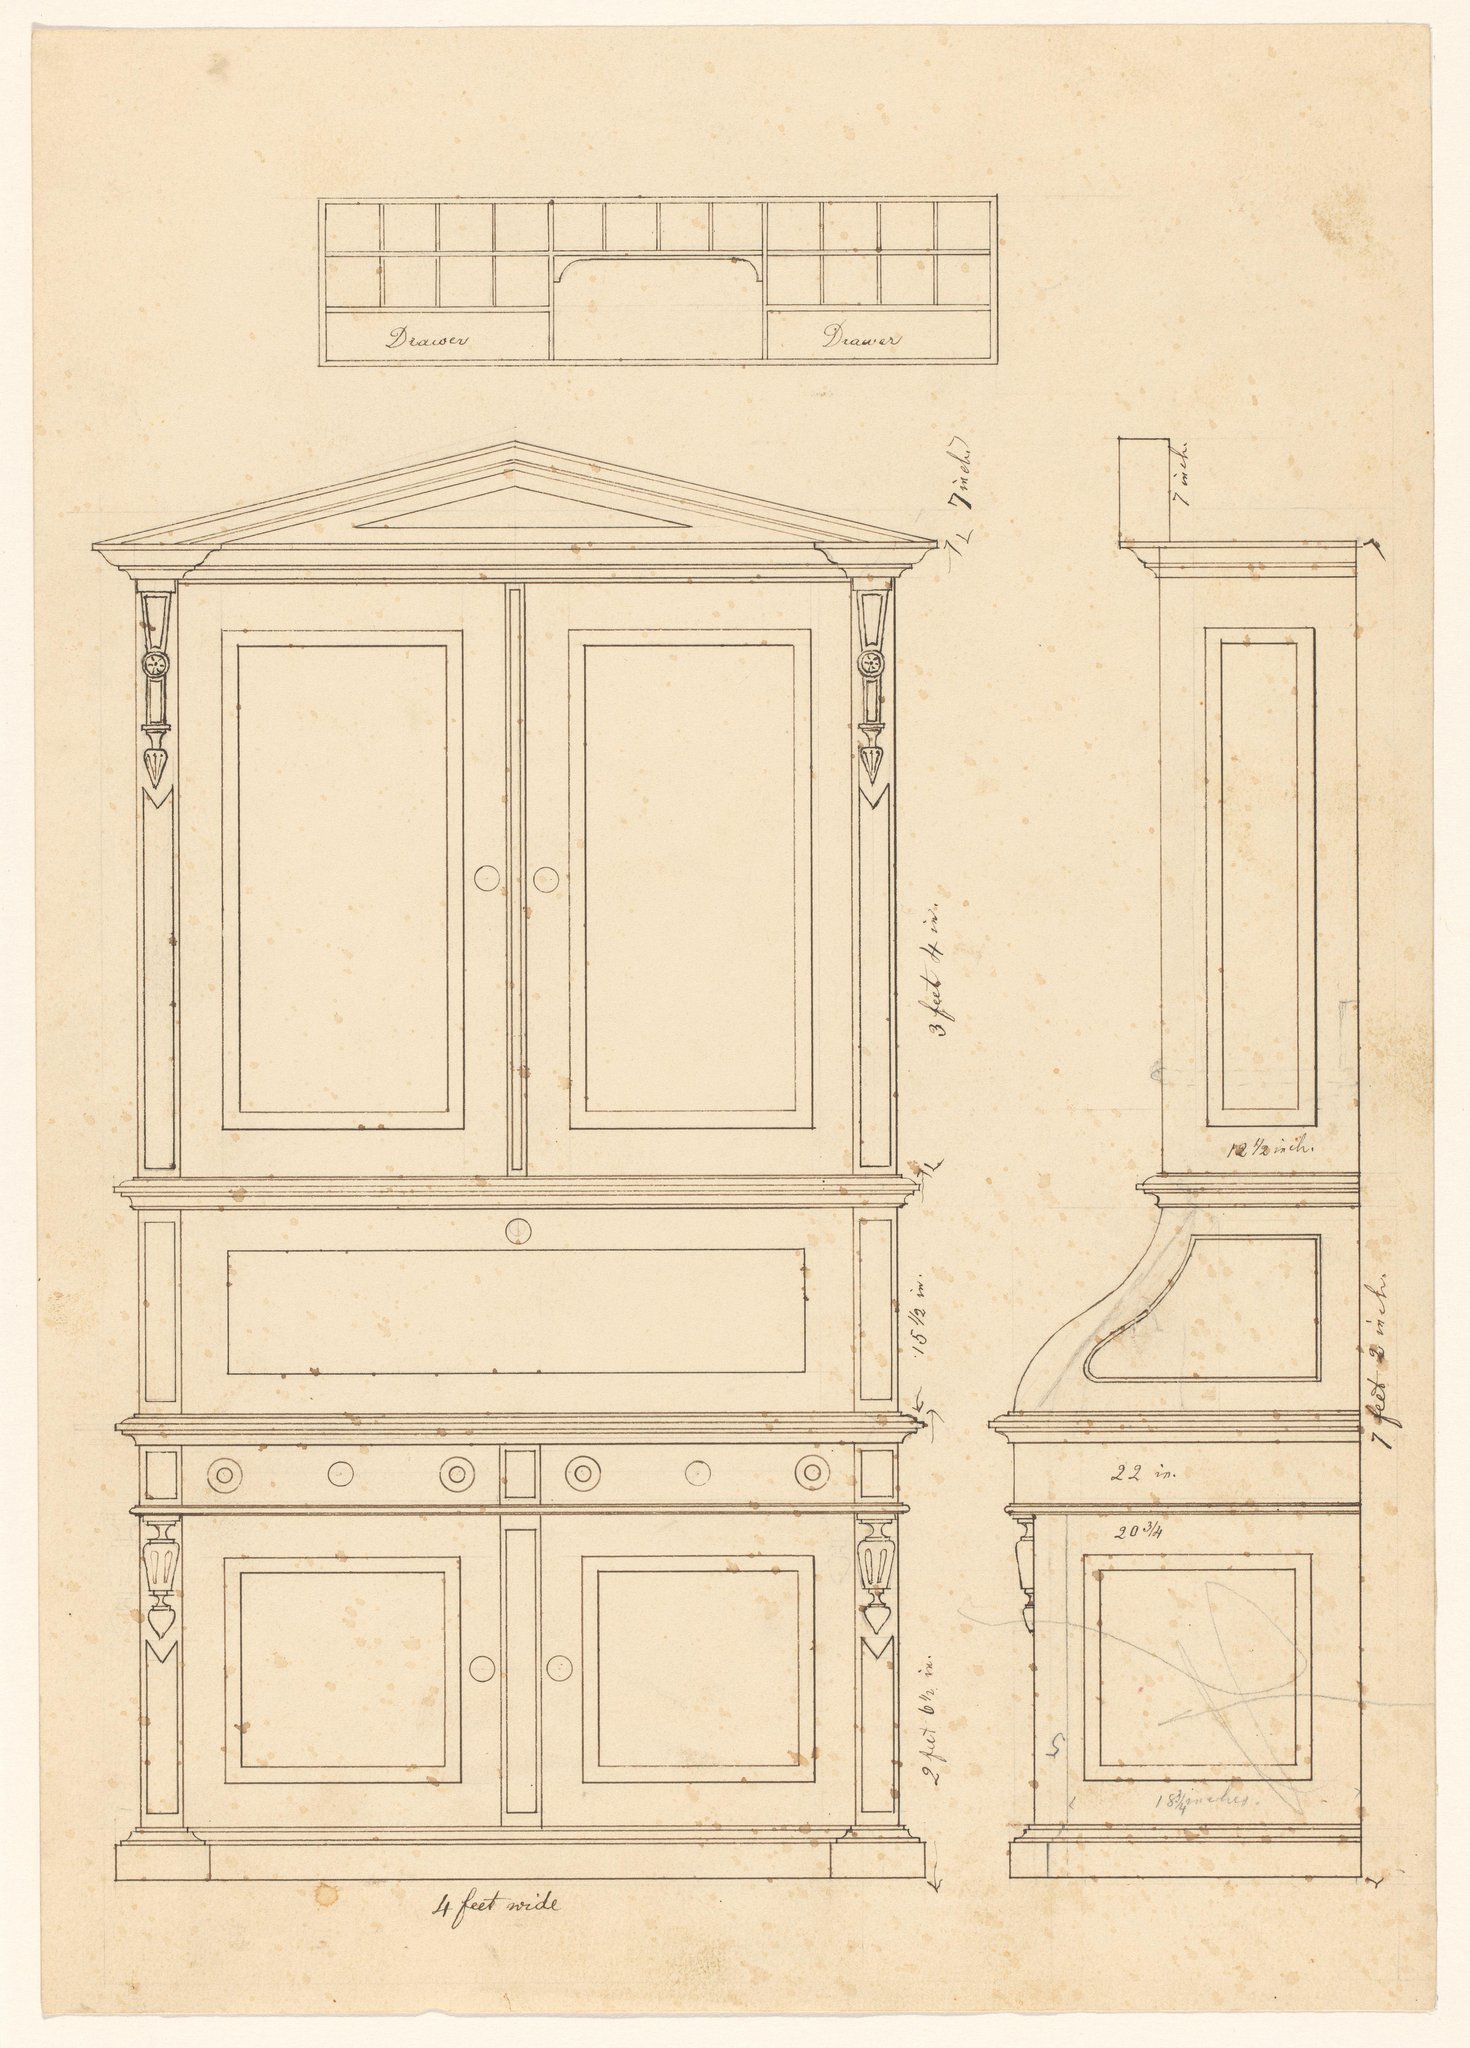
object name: drawing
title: Ontwerp voor een bureau met opstand, met zijaanzicht en detail van het interieur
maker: joseph kusterer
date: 1866-1870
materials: graphite, ink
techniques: drawing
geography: mainz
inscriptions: inscription: ‘4 feet wide’, inscription: ‘12 ½ inch. / 22 in. / 20 ¾ / 5 / 18 ¾ inches’, inscription: ‘7 feet 2 inch / 7 inch’, inscription: ‘2 feet 6 ½ in. / 15 ½ in. / 3 feet 4 in. / 7 inches’, inscription: ‘Drawer / Drawer’, watermark: ‘J WHATMAN / 1866’